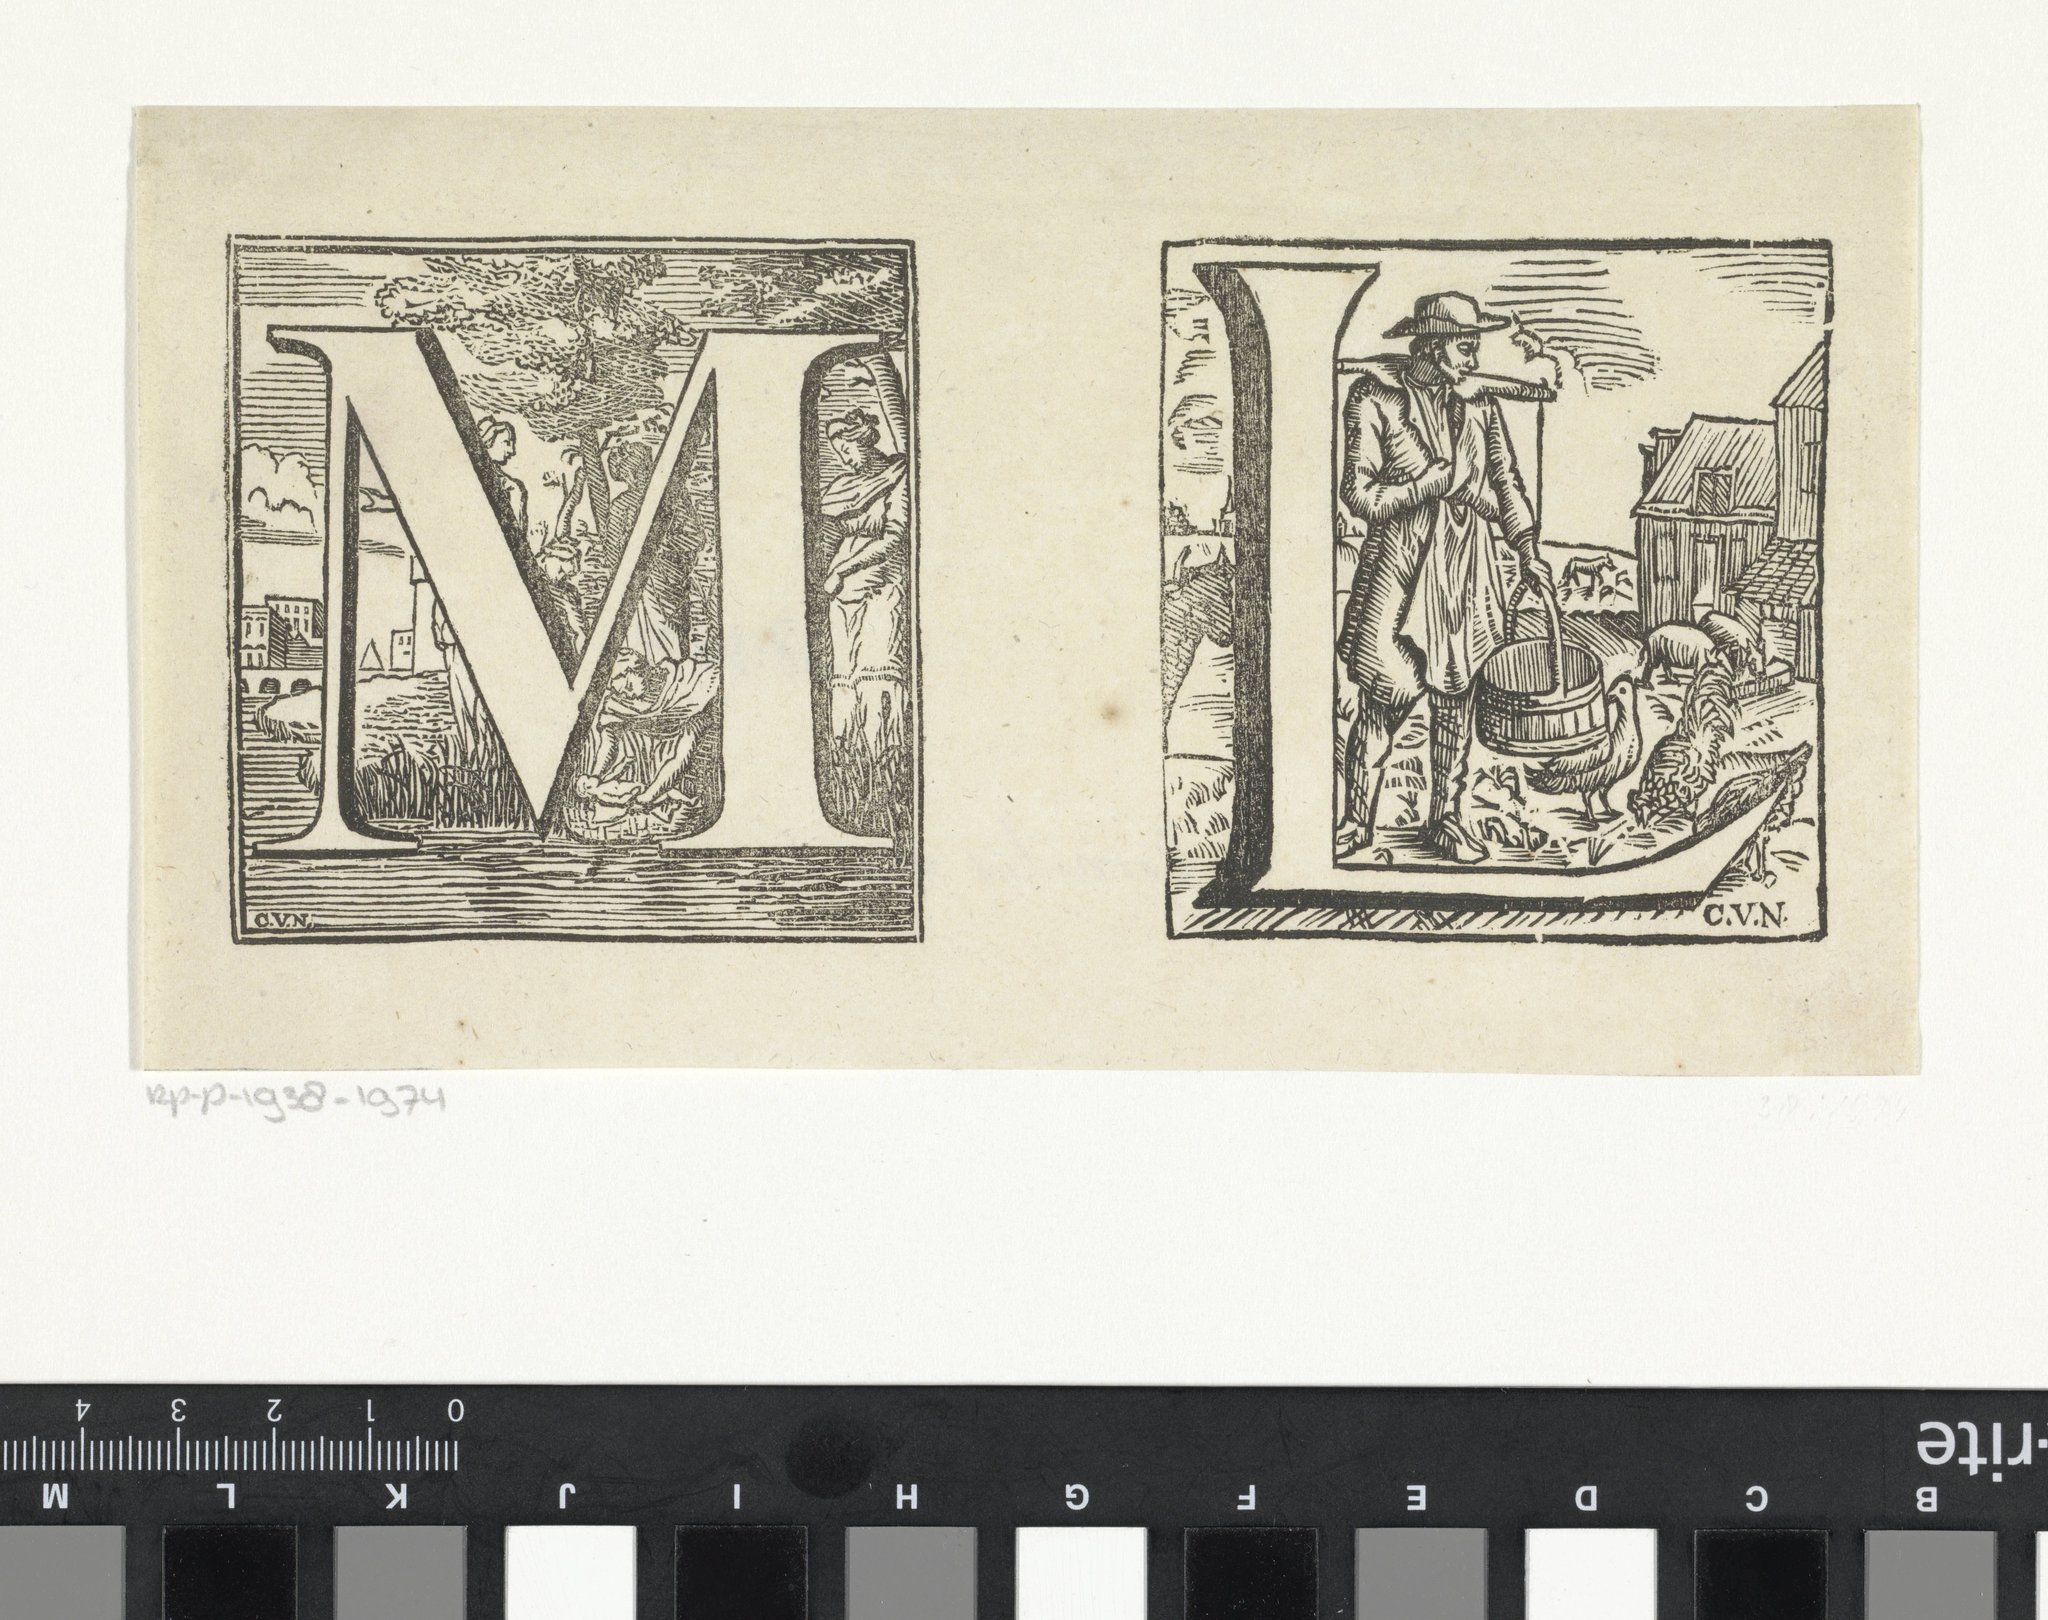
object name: print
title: Letters M en L in omlijstingen met een voorstelling van Mozes die gevonden wordt door de dochter van de farao en een boer die zijn beesten voert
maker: cornelis van noorde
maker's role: draughtsman, print maker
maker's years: 1731-1795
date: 1741-1795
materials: paper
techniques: woodcut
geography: haarlem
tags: pig, fowl (cock, hen, chicken, etc.), fancy letters, horse, the finding of moses: pharaoh's daughter comes to bathe with her maidens in the river and discovers the child floating on the water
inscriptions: collector's mark: Lugt 2760